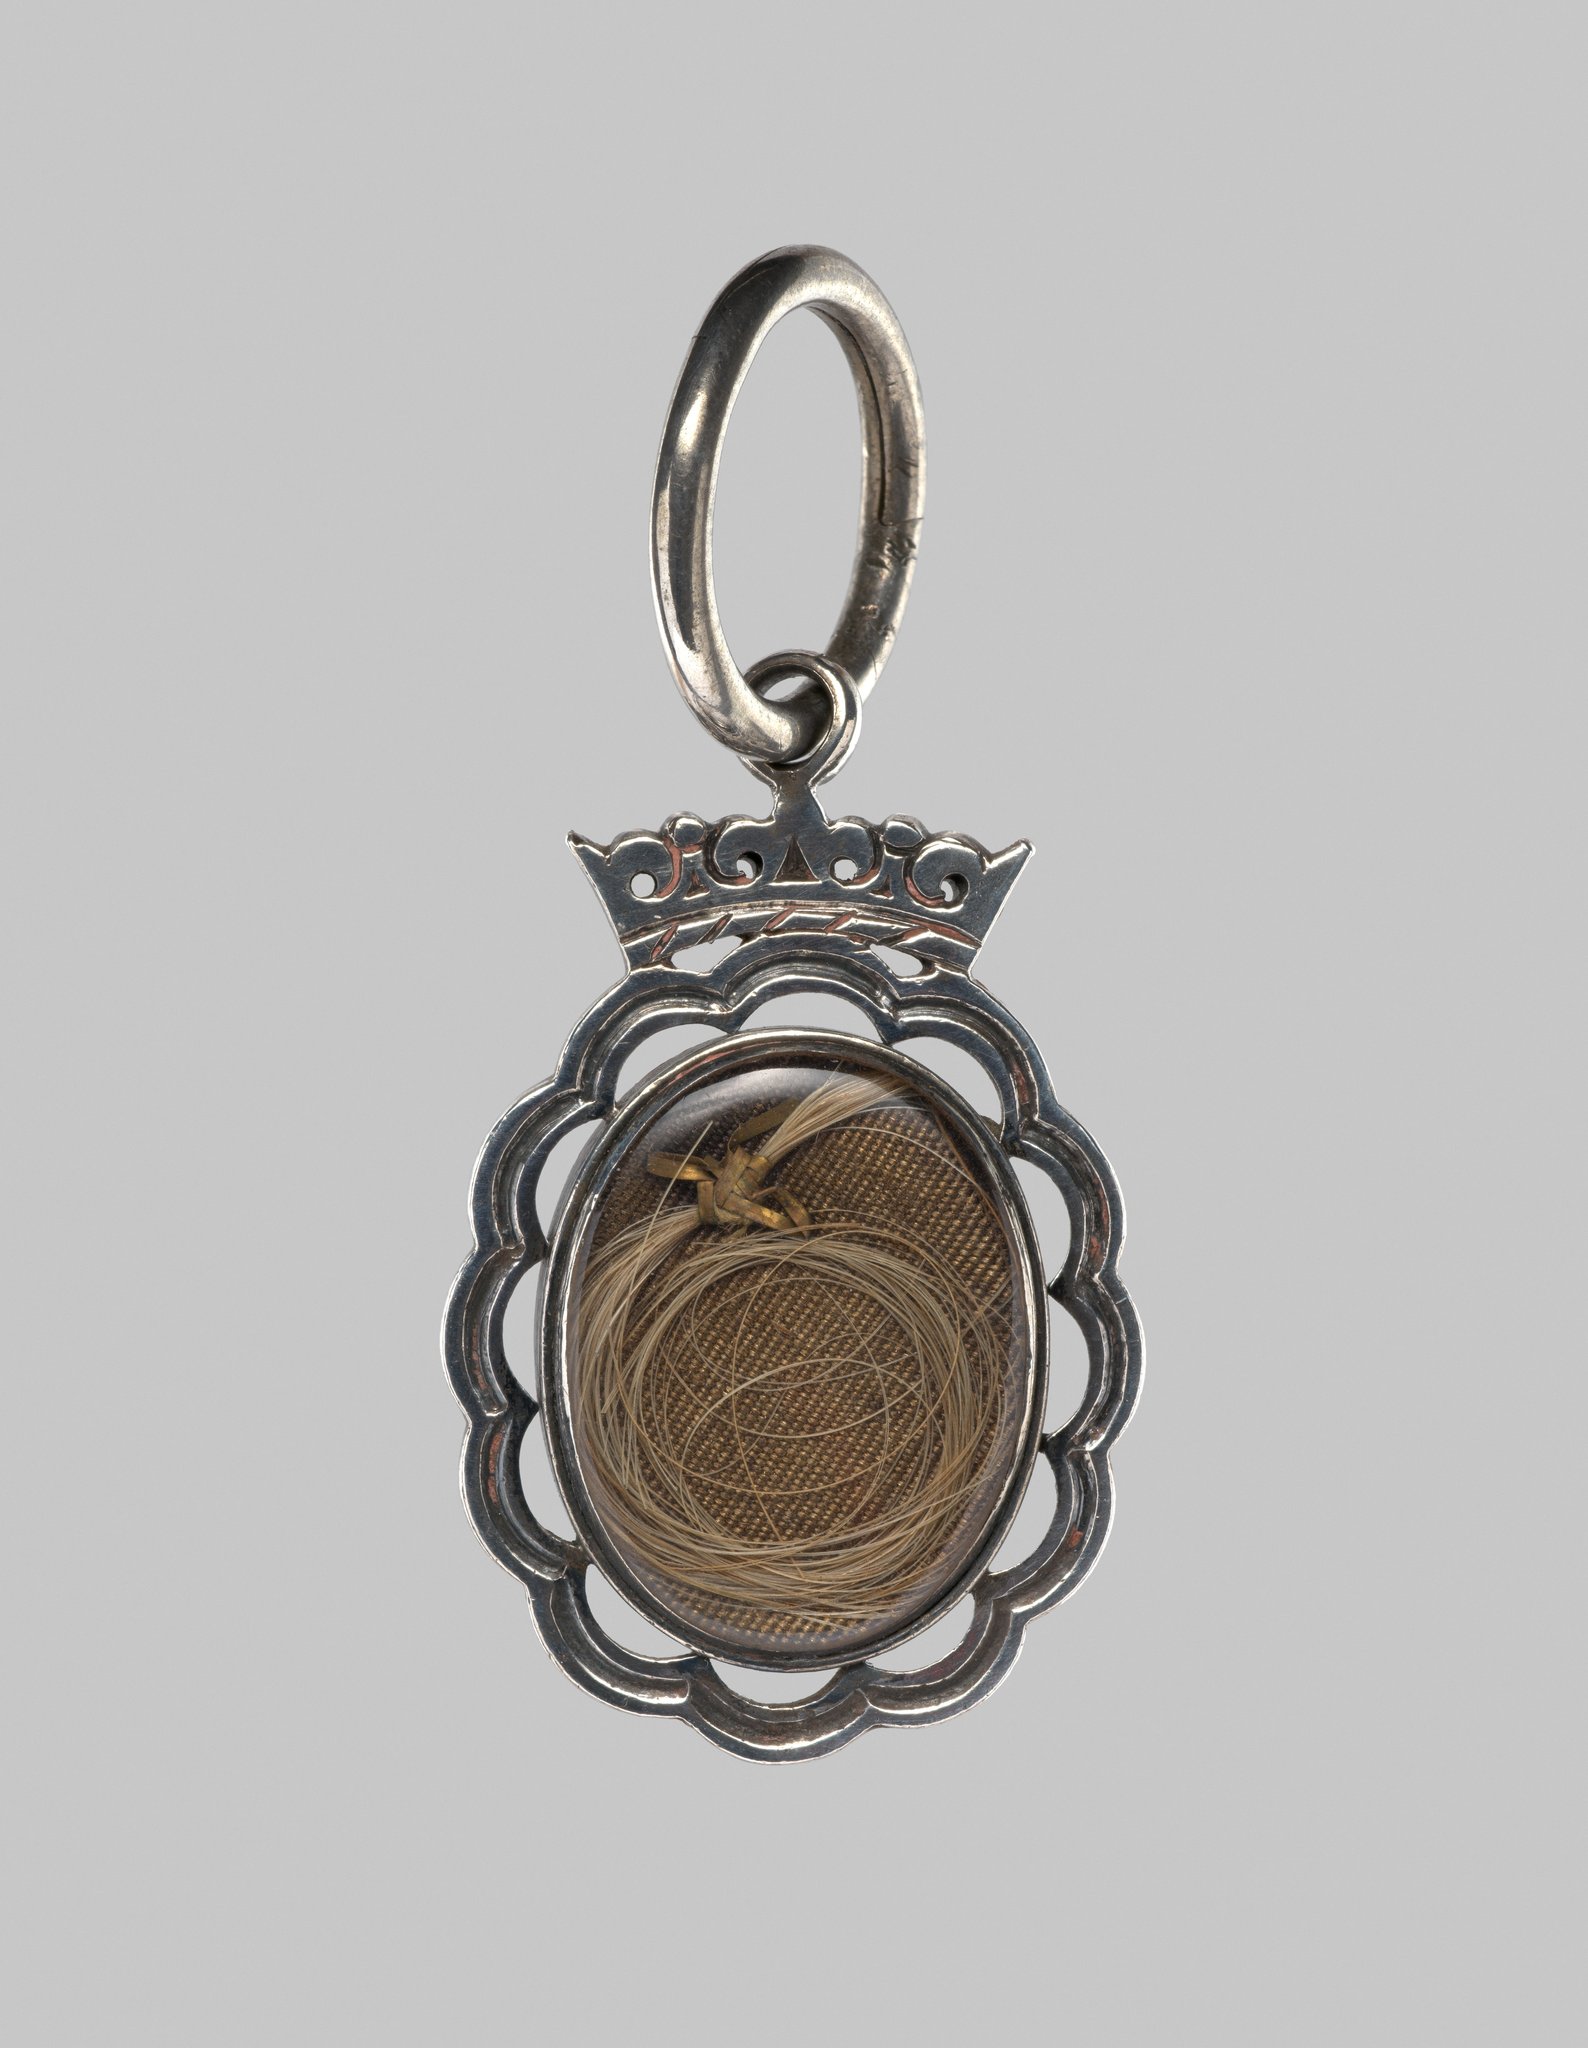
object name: locket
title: Locket containing lock of Prince Charles Edward's hair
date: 1746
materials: hair, silver gilt